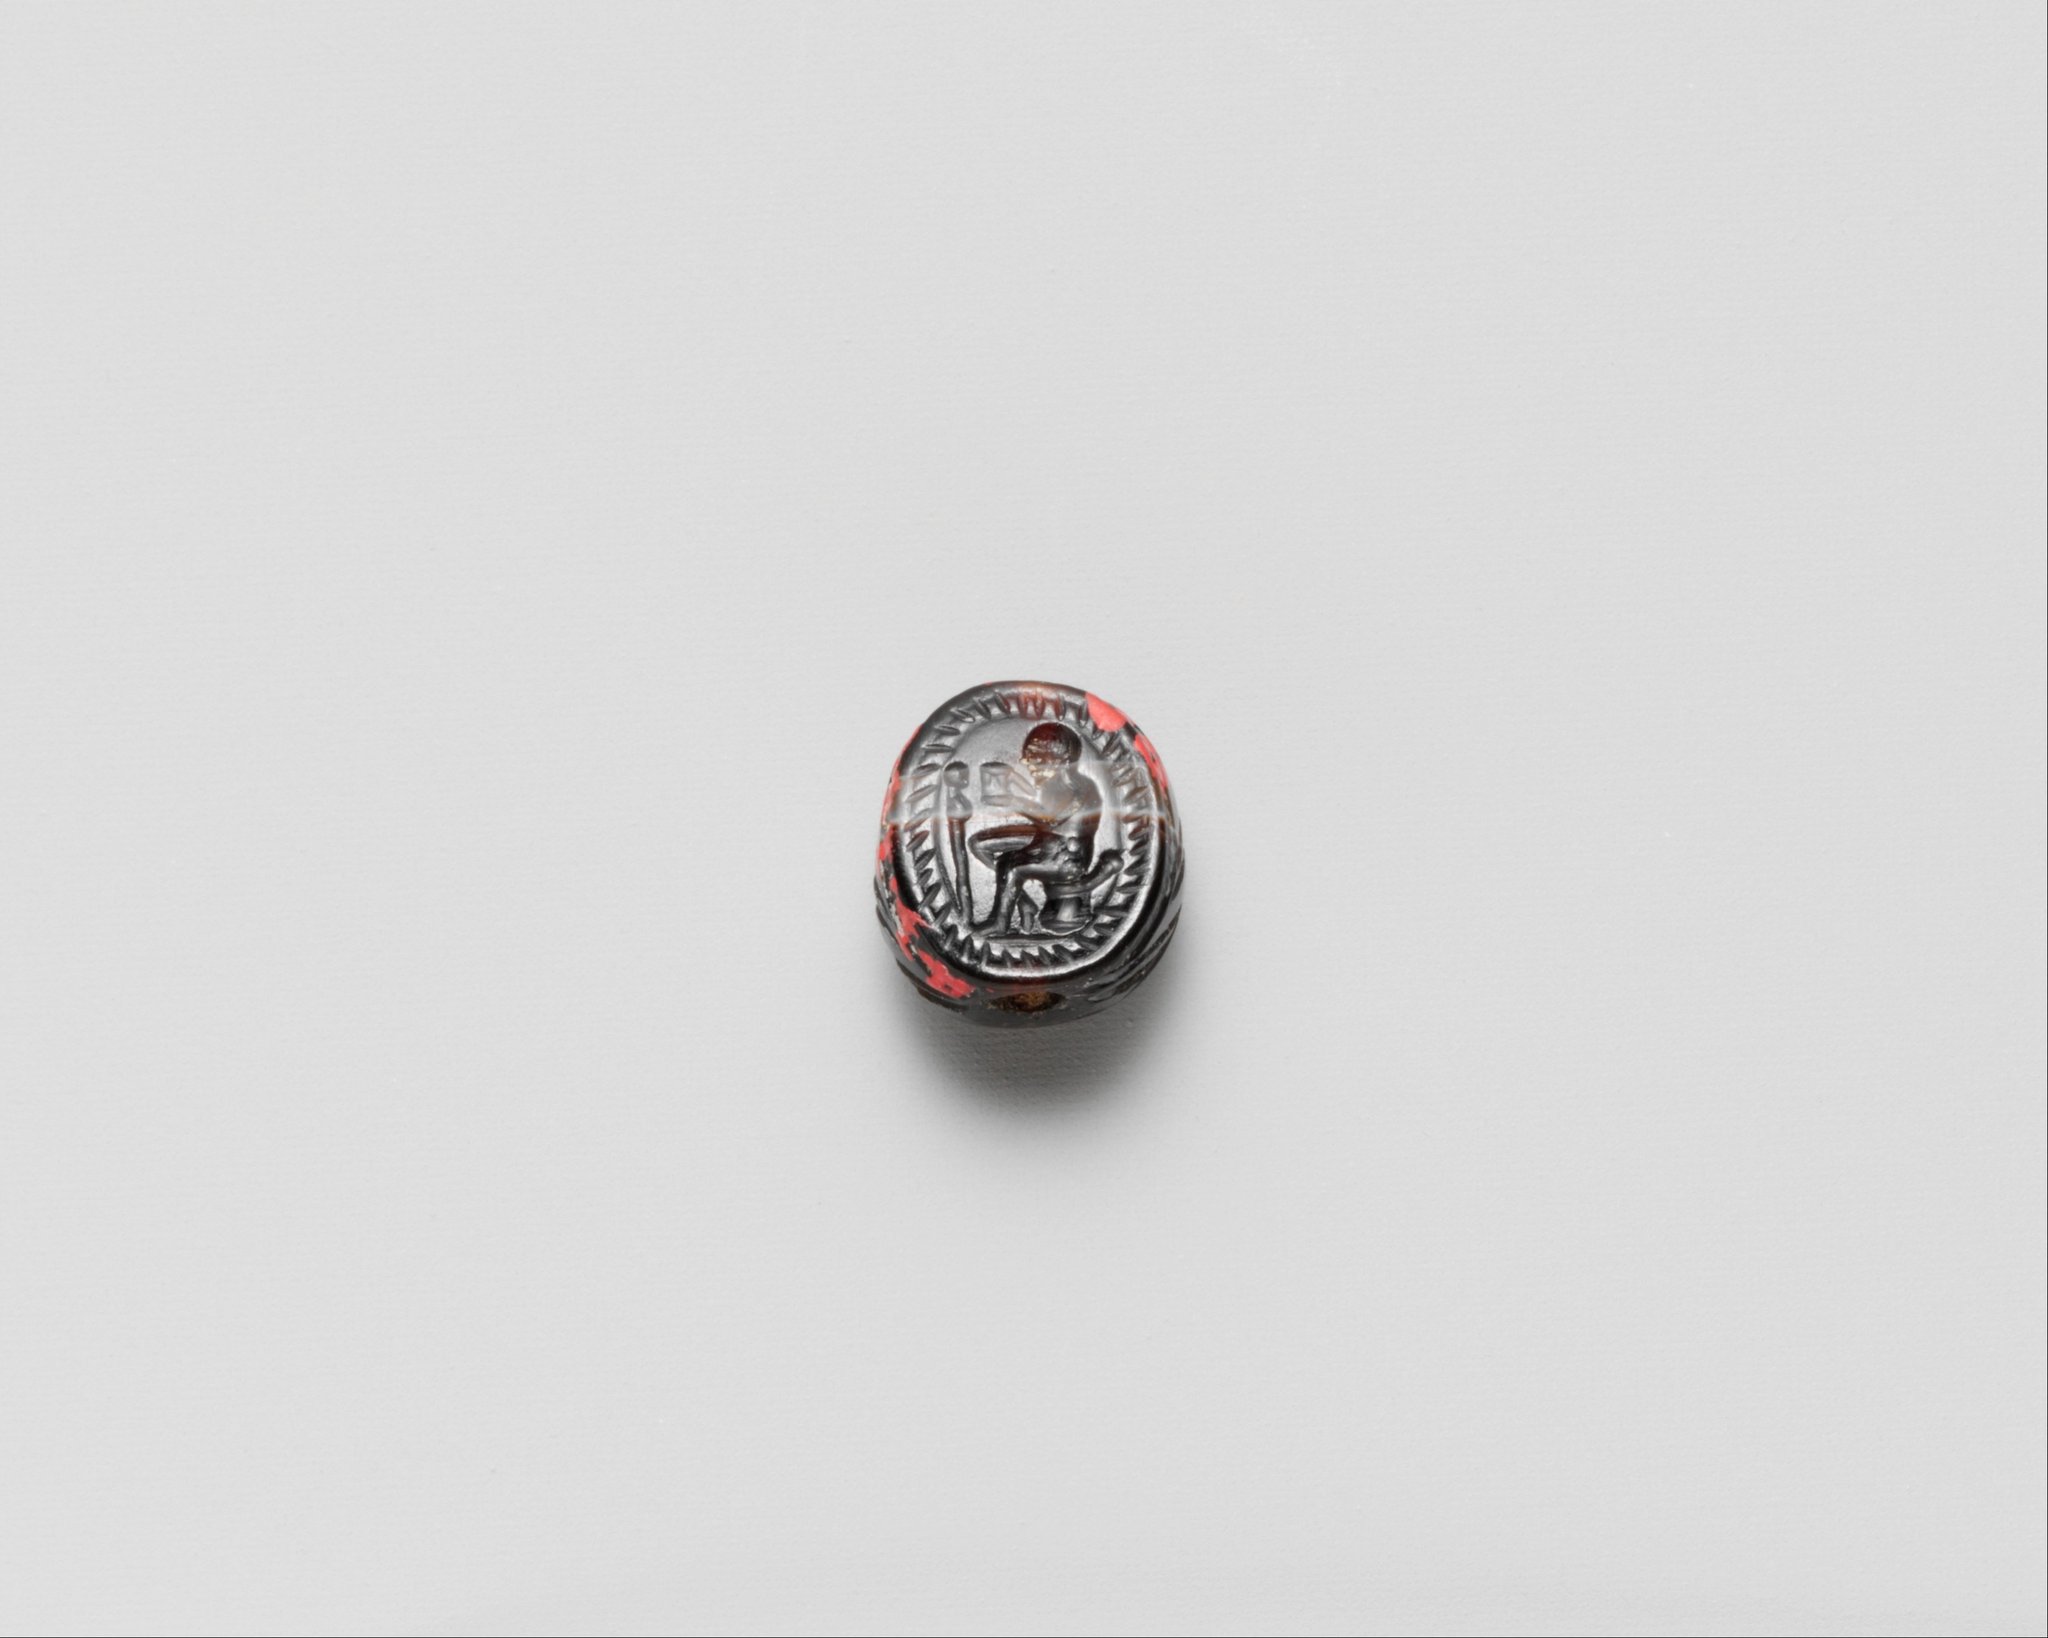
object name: scarab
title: Agate scarab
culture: etruscan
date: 400-301 BCE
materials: stone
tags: men,reading,scarabs